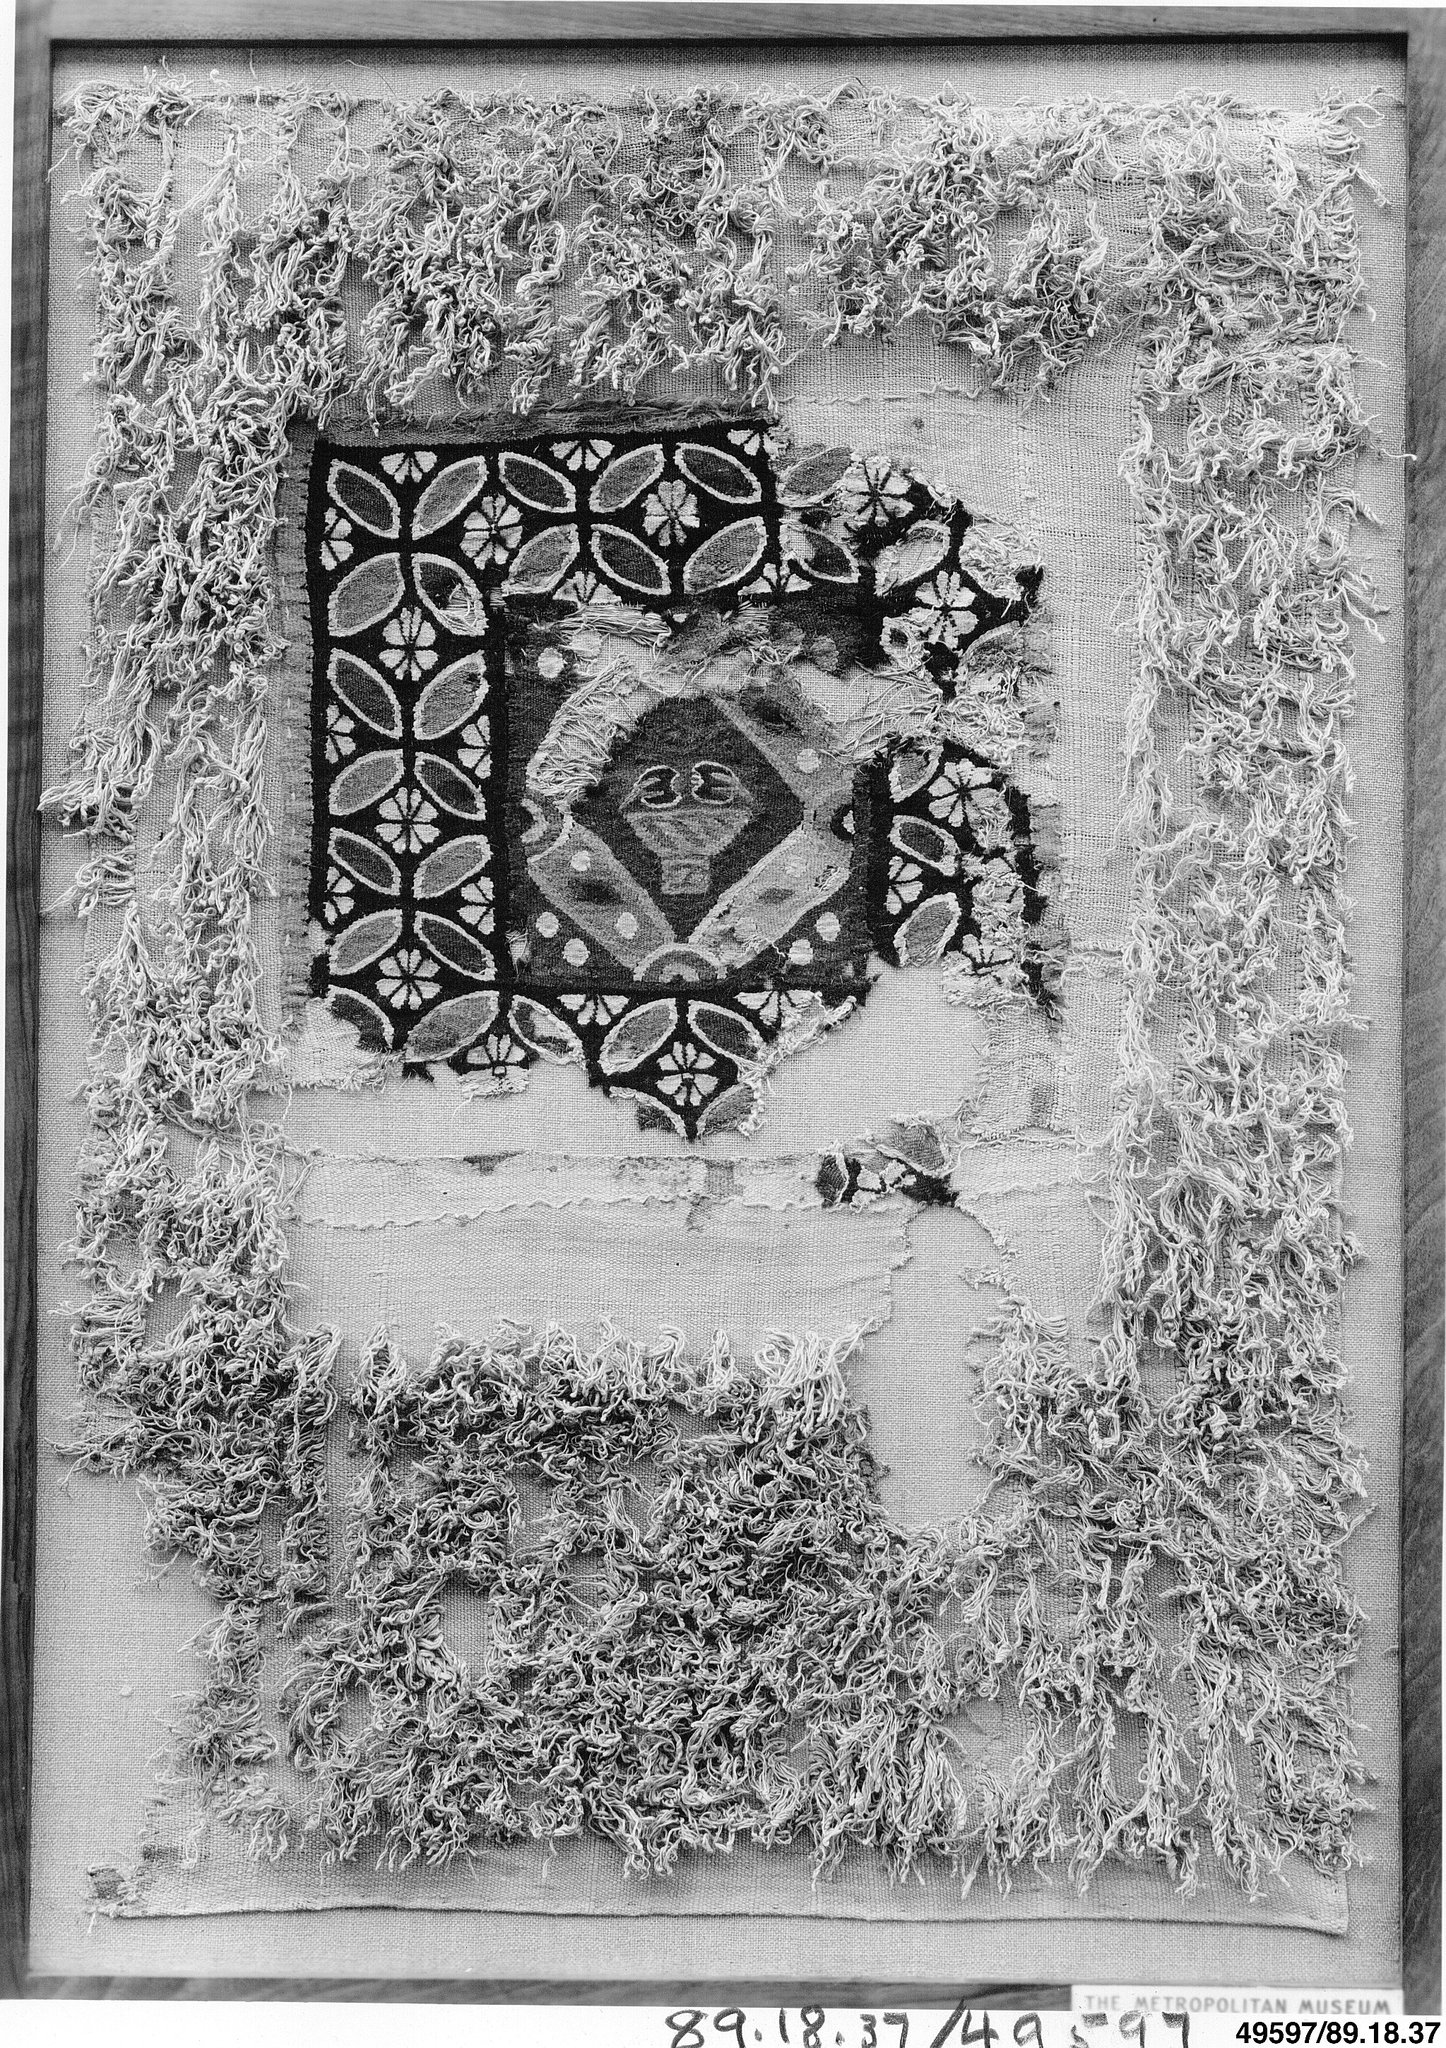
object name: textile fragment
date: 301-500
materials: linen, wool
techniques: weave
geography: egypt